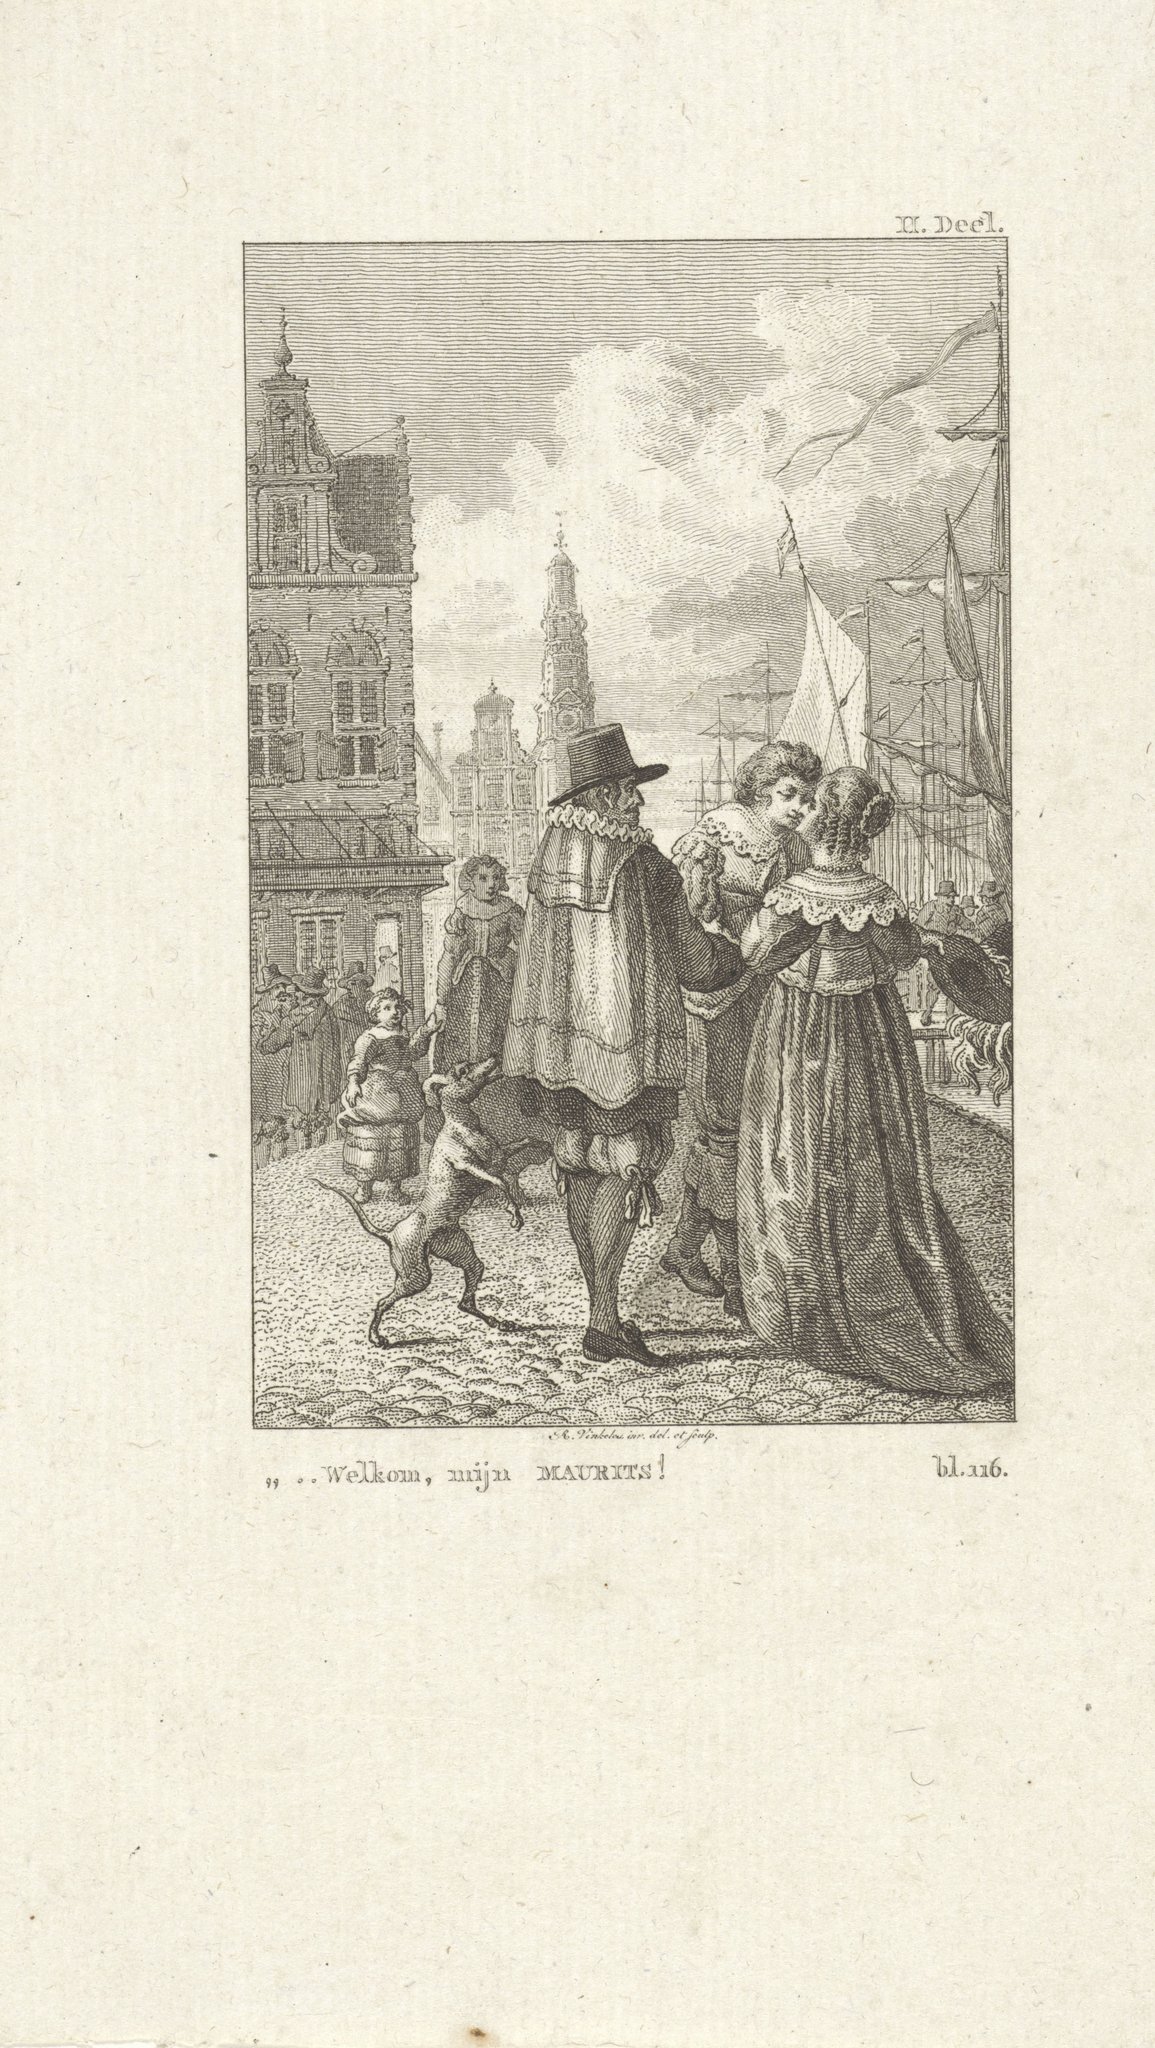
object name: print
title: ..Welkom, mijn Maurtis!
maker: reinier vinkeles (i)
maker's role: draughtsman, print maker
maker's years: 1741-1816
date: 1808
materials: paper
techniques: engraving, etching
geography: amsterdam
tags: sailing-ship, sailing-boat, being welcomed ~ travelling, quay, dog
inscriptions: collector's mark: Lugt 2228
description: Deze prent is ook gebruikt als illustratie voor: Loosjes, Adriaan Pietersz. Het leven van Maurits Lijnslager : eene Hollandsche familiegeschiedenis uit de zeventiende eeuw. Haarlem: Adriaan Pietersz. Loosjes, 1808, p. 116.